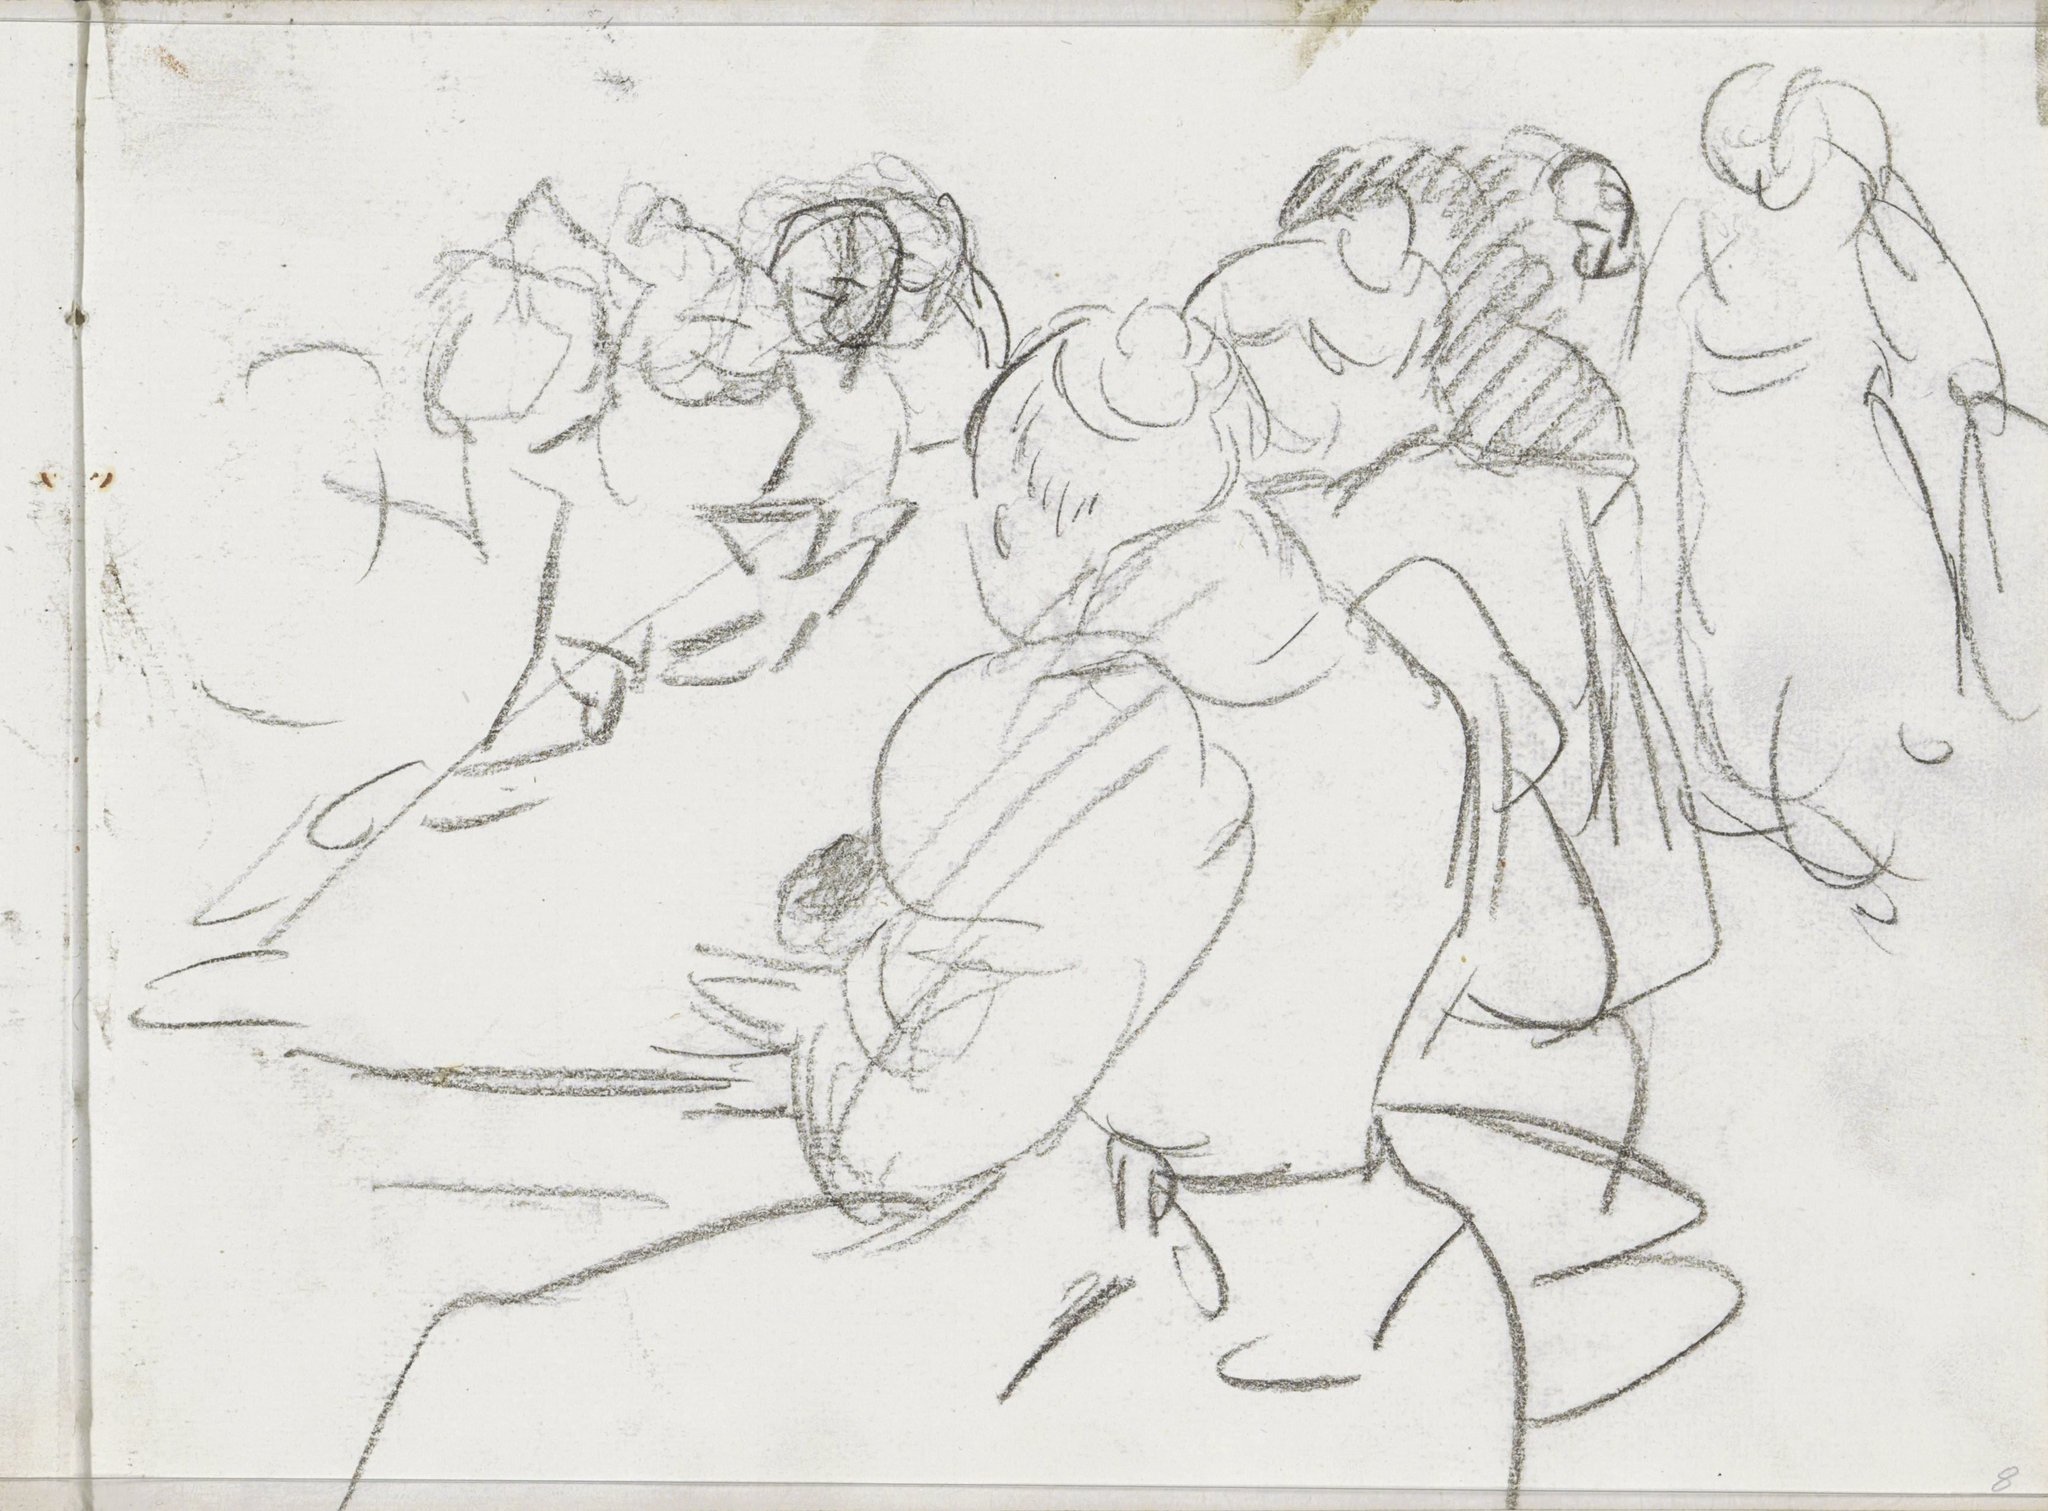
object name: sketchbook leaf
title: Vrouwen aan een tafel, mogelijk koffiepiksters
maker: isaac israels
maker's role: draughtsman, painter, print maker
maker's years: 1865-1934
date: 1875-1934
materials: chalk, paper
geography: amsterdam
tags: table, adult woman (+ sitting), working class, labourers - aa - women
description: Blad 8 recto uit schetsboek XX met 26 bladen.